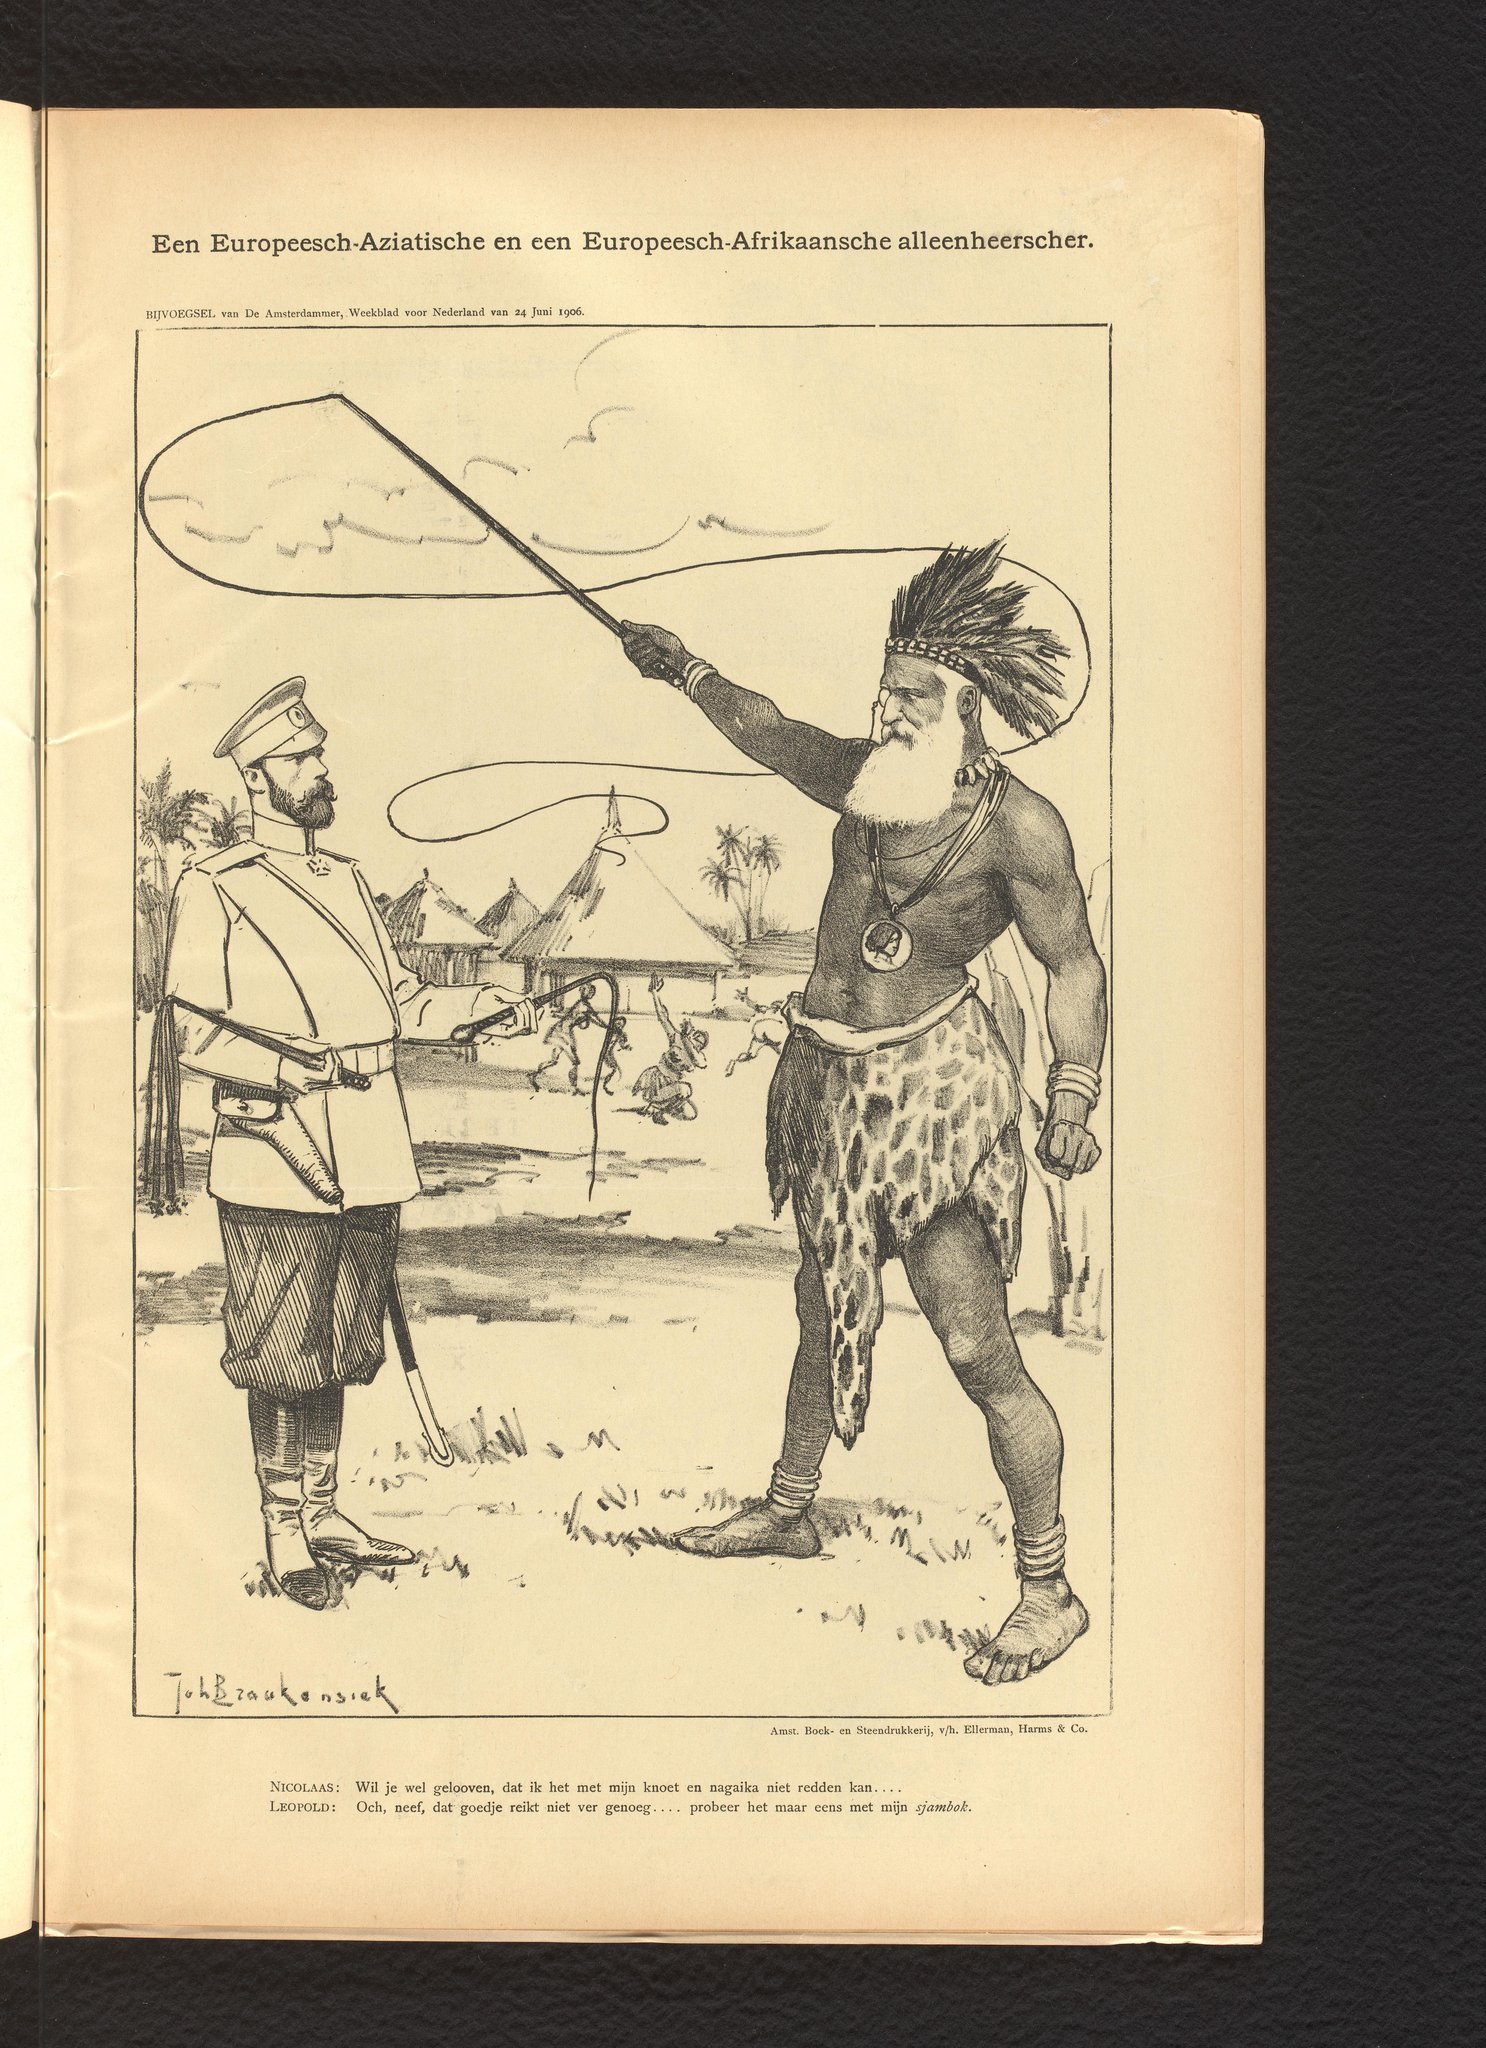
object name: cartoon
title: Een Europeesch-Aziatische en een Europeesch-Afrikaansche alleenheerscher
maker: johan braakensiek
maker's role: draughtsman, print maker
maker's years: 1858-1940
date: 1906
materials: paper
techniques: lithograph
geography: amsterdam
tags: leopold ii (koning der belgen), africans, political caricatures and satires, whip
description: De Russische tsaar Nicolaas II klaagt dat hij met zijn kleine zweep niet genoeg effect bereikt. De Belgische koning Leopold II, uitgedost als een Afrikaanse krijger, laat hem zien dat hij met een lange zweep als de sjambok de inwoners van een Afrikaans dorp angst kan aanjagen.